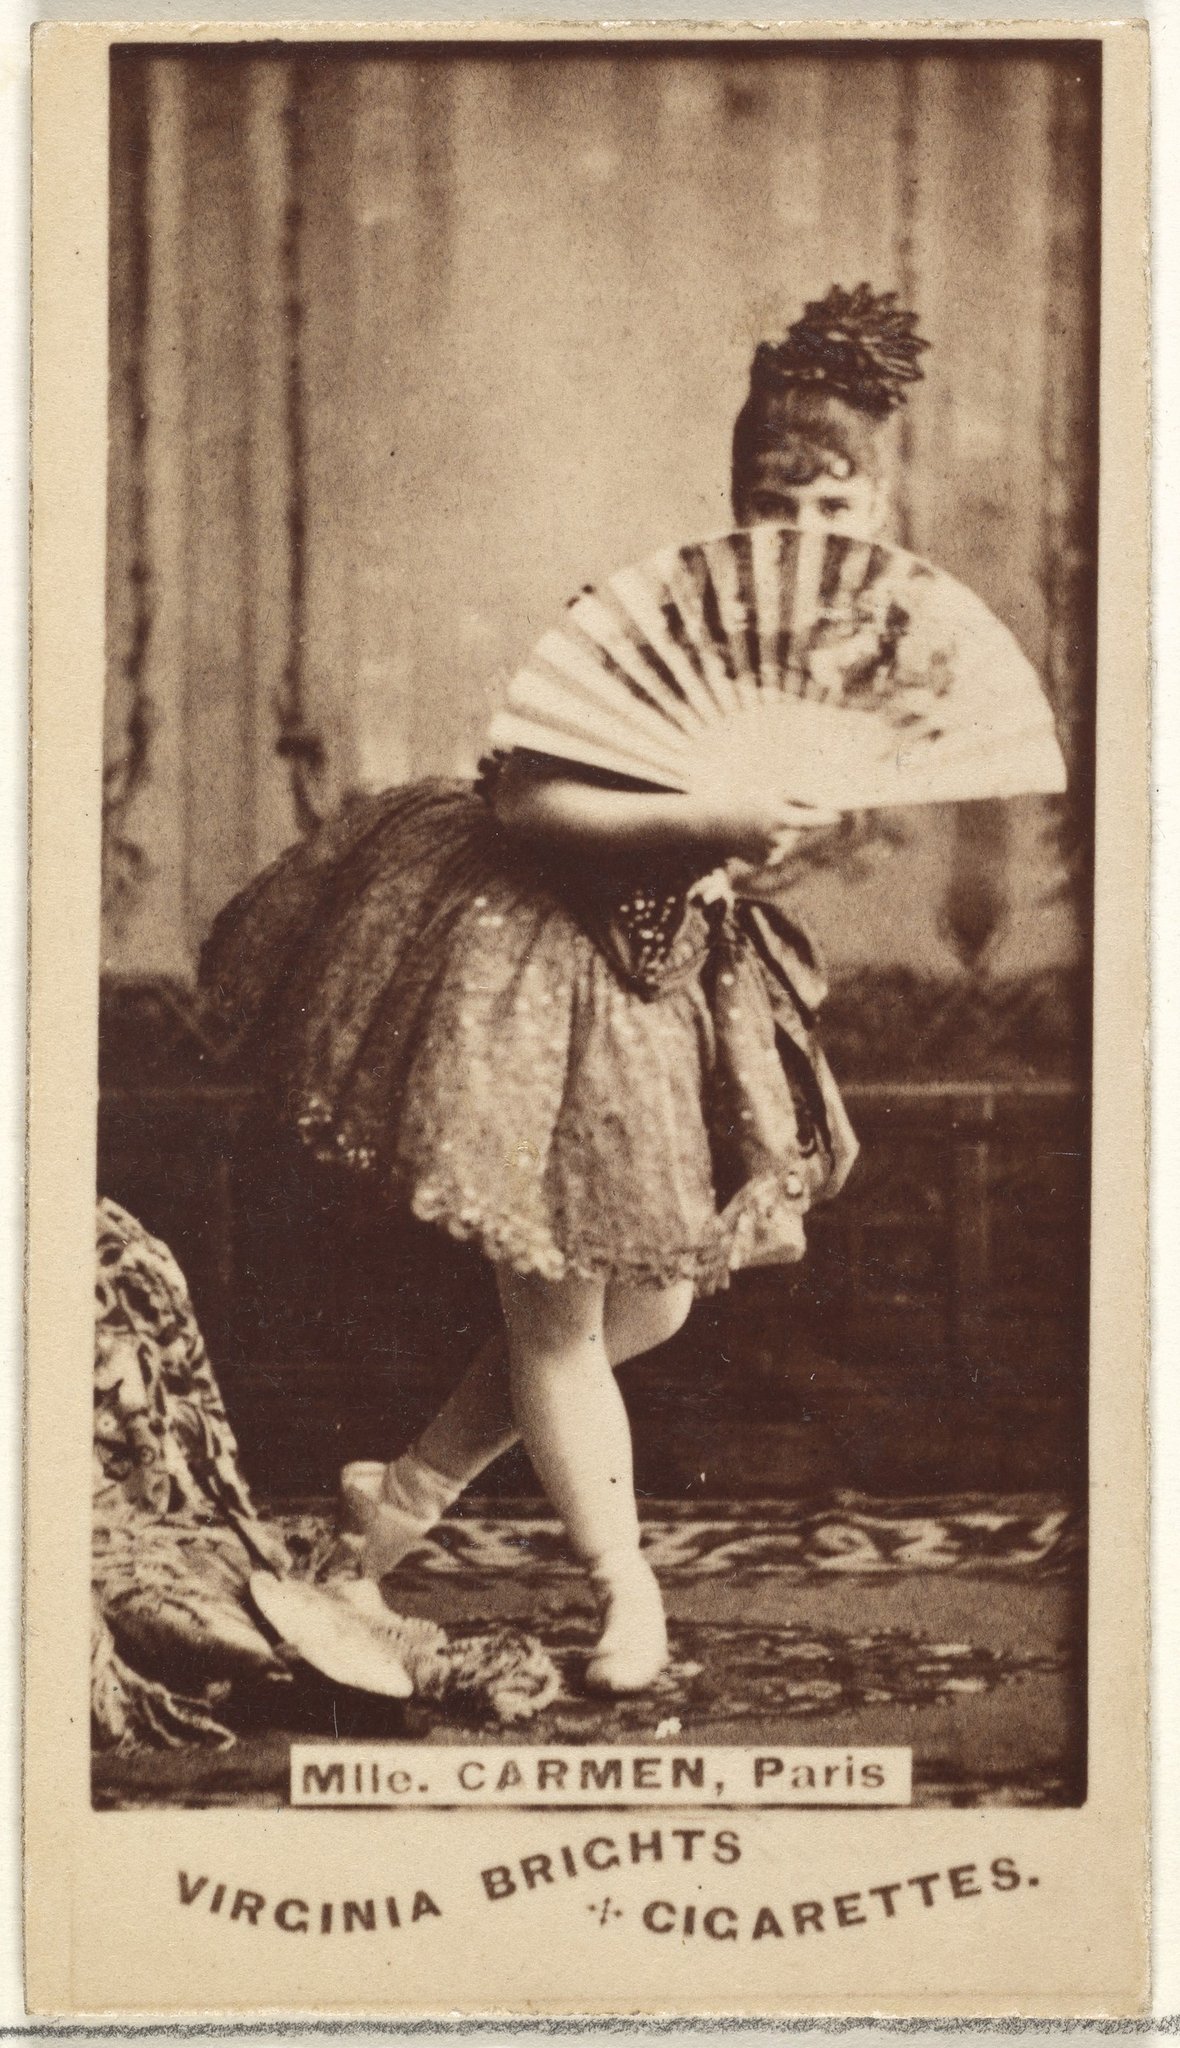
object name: photograph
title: Mlle. Carmen, Paris, from the Actors and Actresses series (N45, Type 1) for Virginia Brights Cigarettes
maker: allen & ginter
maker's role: publisher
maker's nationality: american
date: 1888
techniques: albumen silver print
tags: fans,portraits,women,dancers